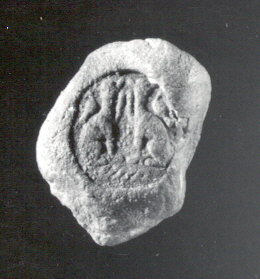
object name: sealing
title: Sealing with one circular seal impression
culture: assyrian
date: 1800-1701 BCE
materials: clay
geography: anatolia